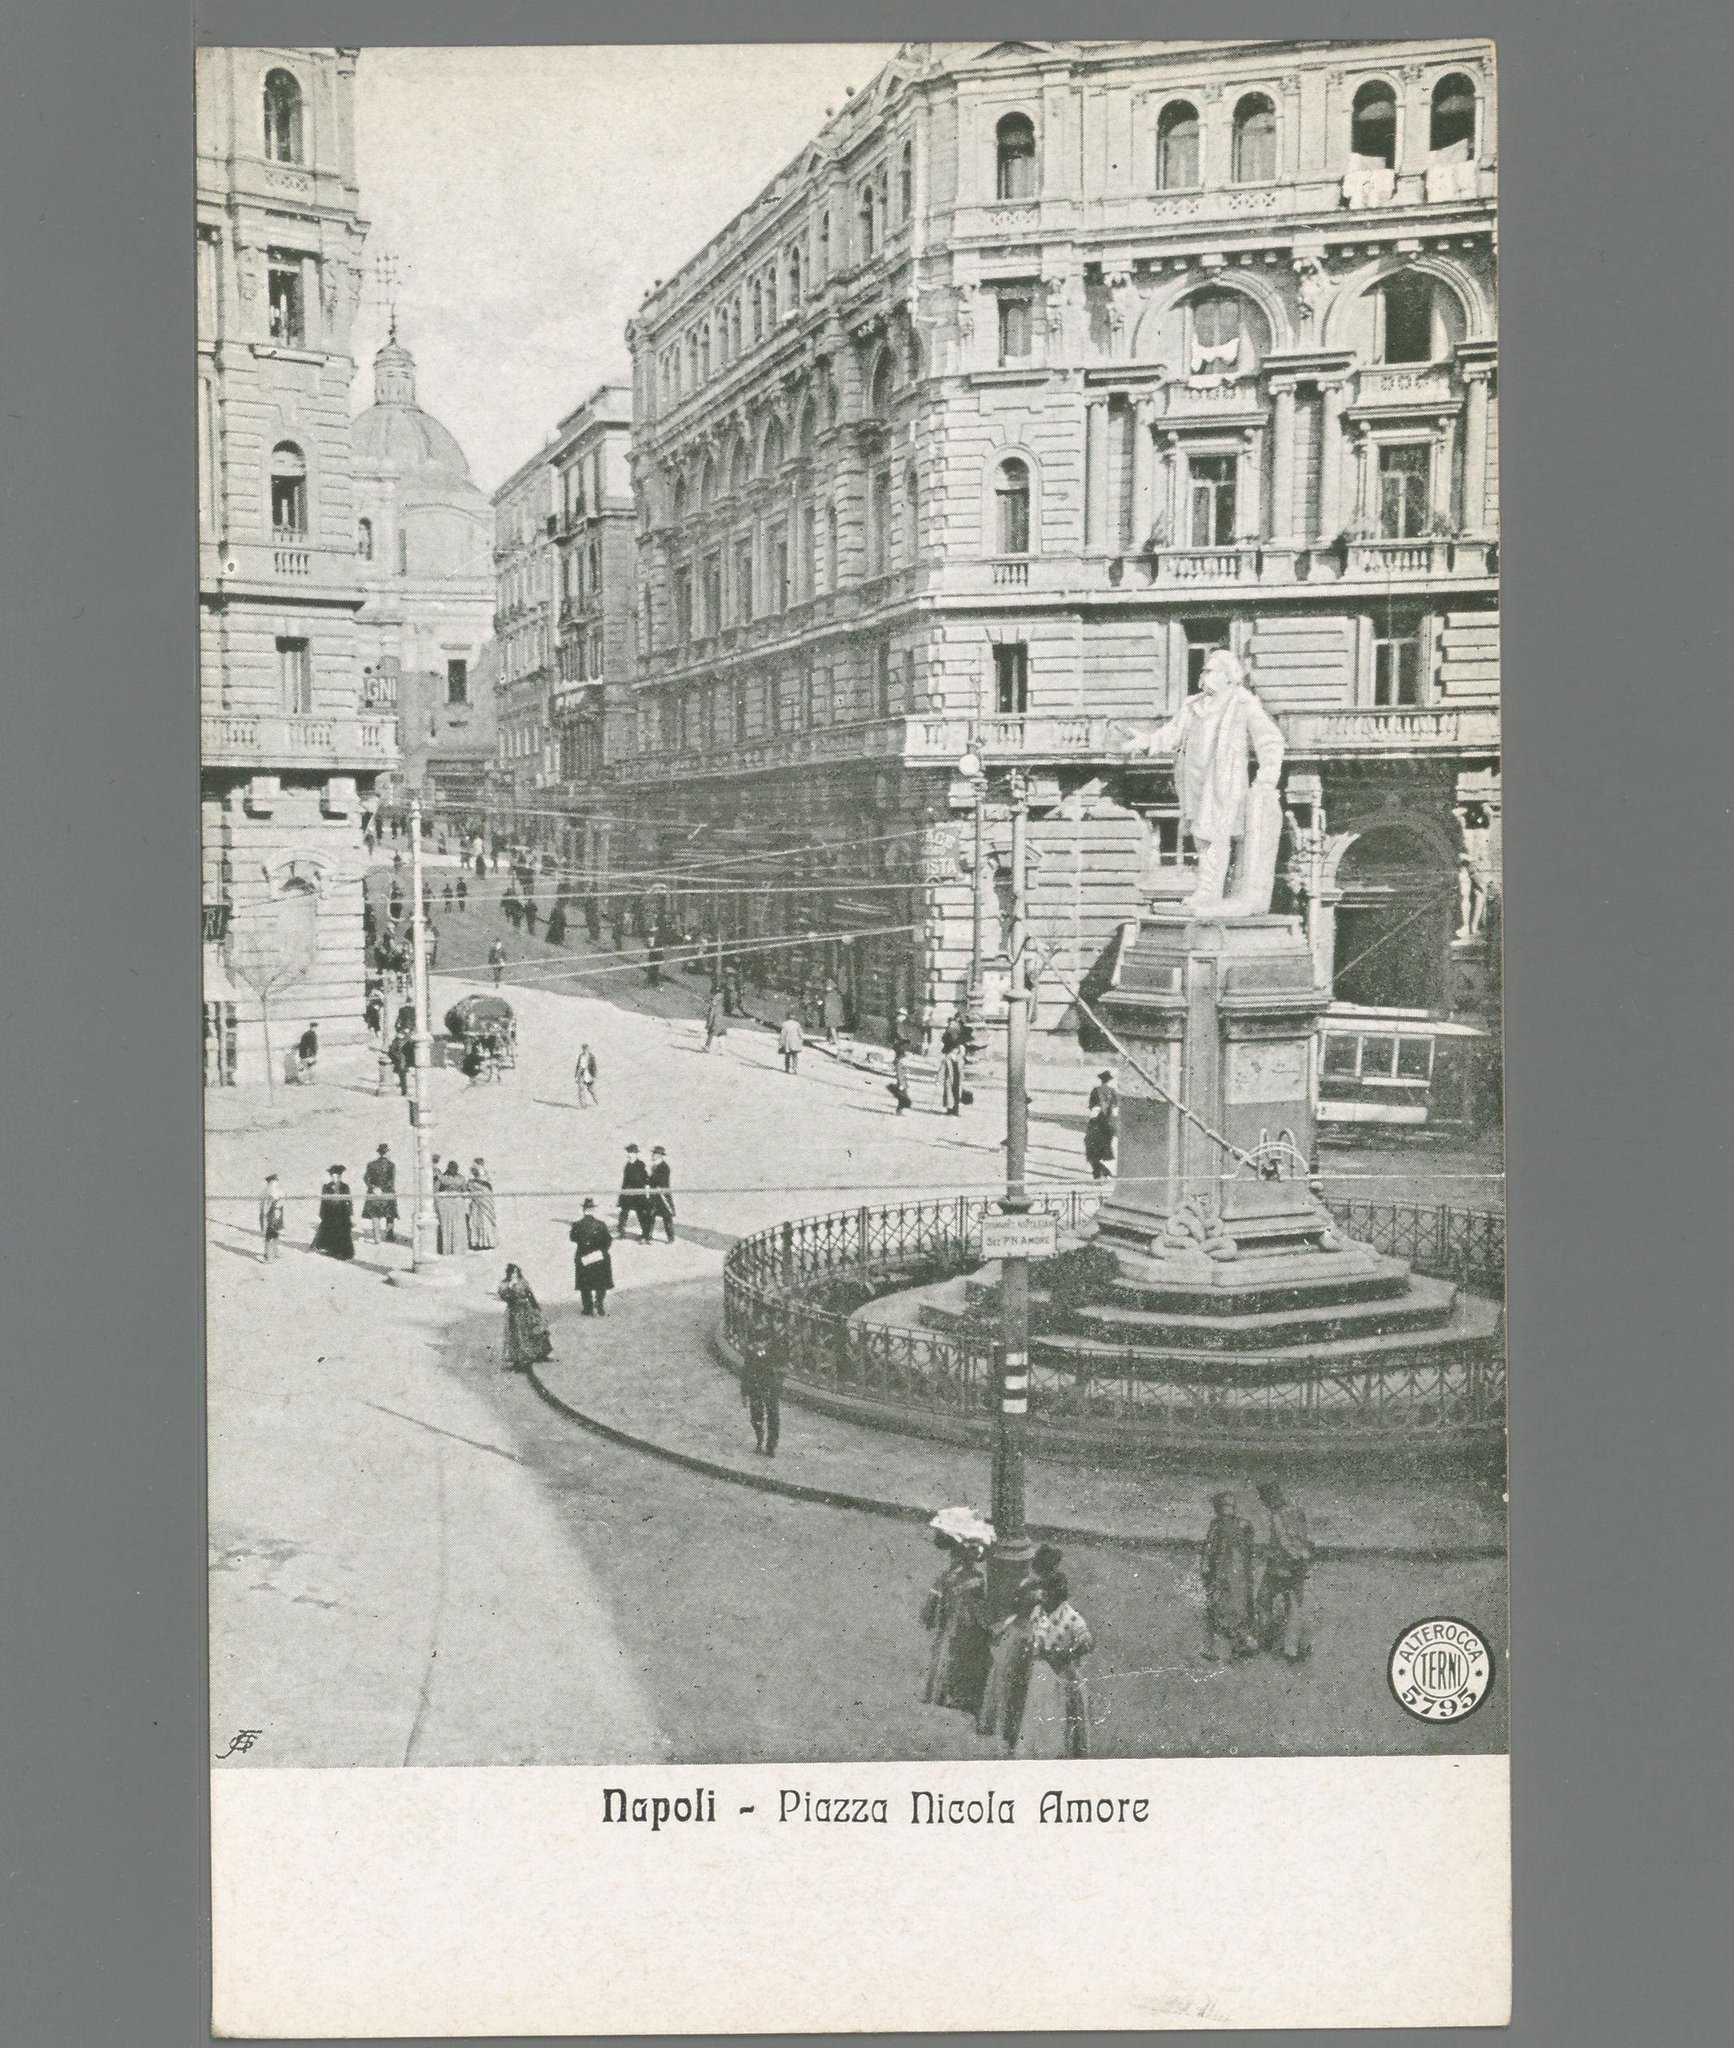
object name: photomechanical print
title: Napoli. Piazza Nicola Amore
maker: Anonymous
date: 1906-1910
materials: cardboard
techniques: autotype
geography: naples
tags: monument, statue, square, place, circus, etc. (+ city(-scape) with figures, staffage), naples